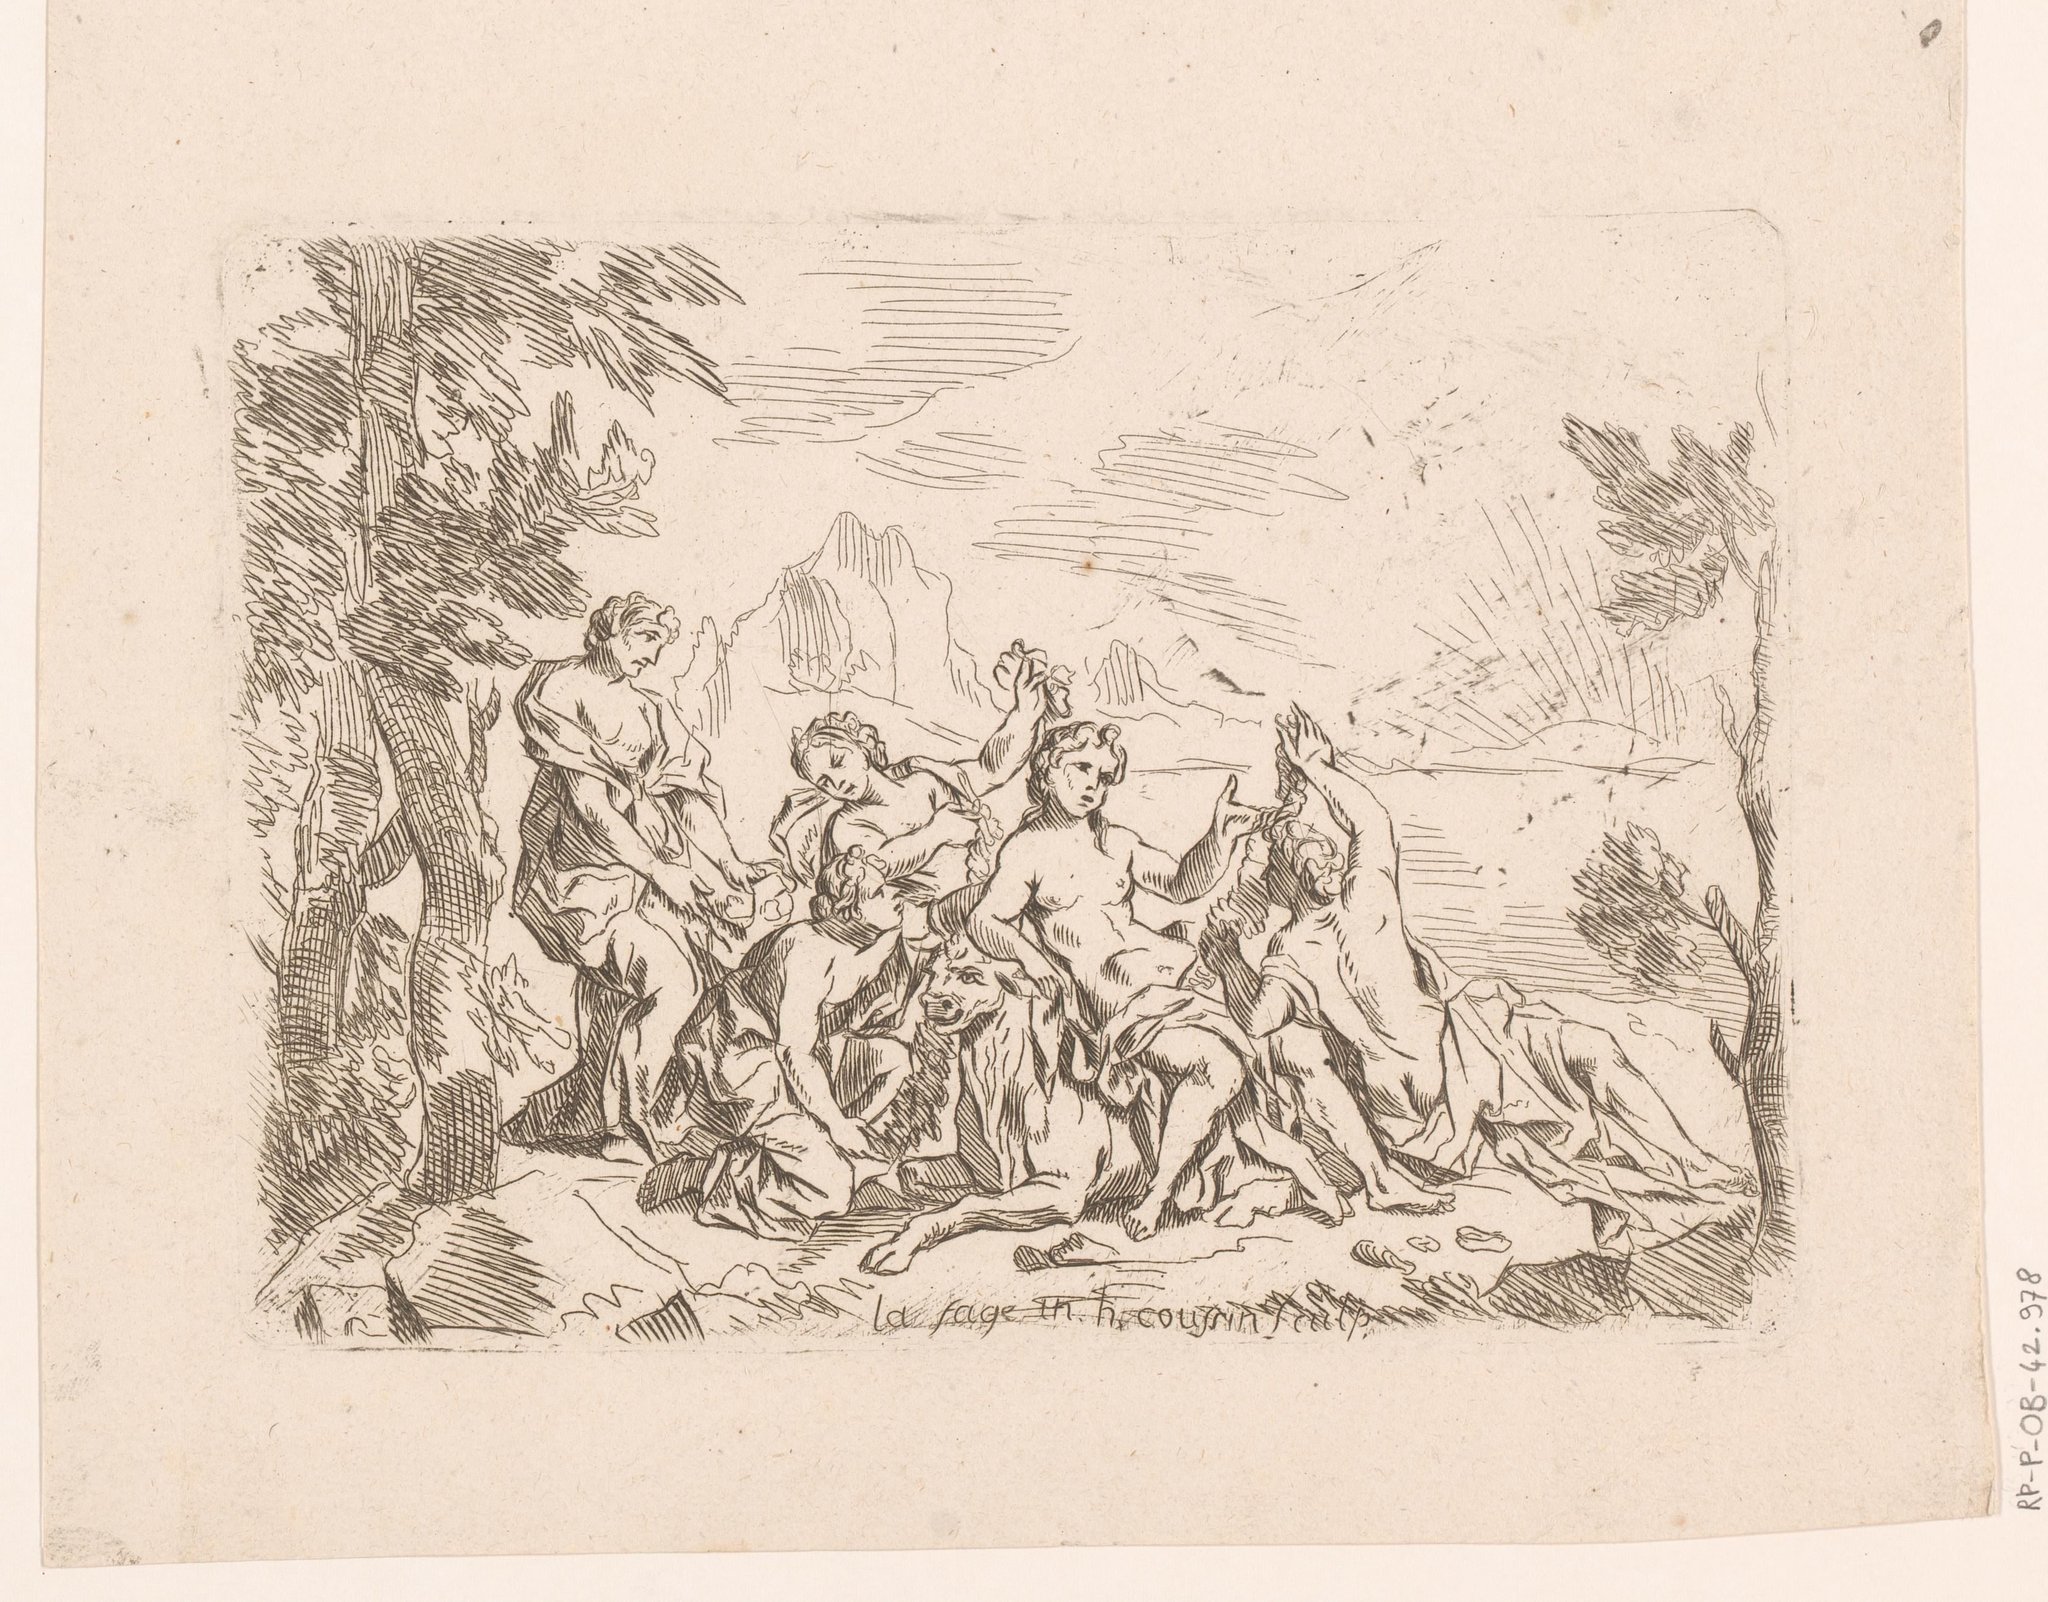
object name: print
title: Europa en de stier en Maria ten hemelopneming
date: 1708-1779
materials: paper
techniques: etching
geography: france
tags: the assumption of mary ('assumptio corporis'): she is borne into heaven by angels, europa and her maidens play with the bull, and/or adorn it with flowers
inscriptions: collector's mark: Lugt 2165